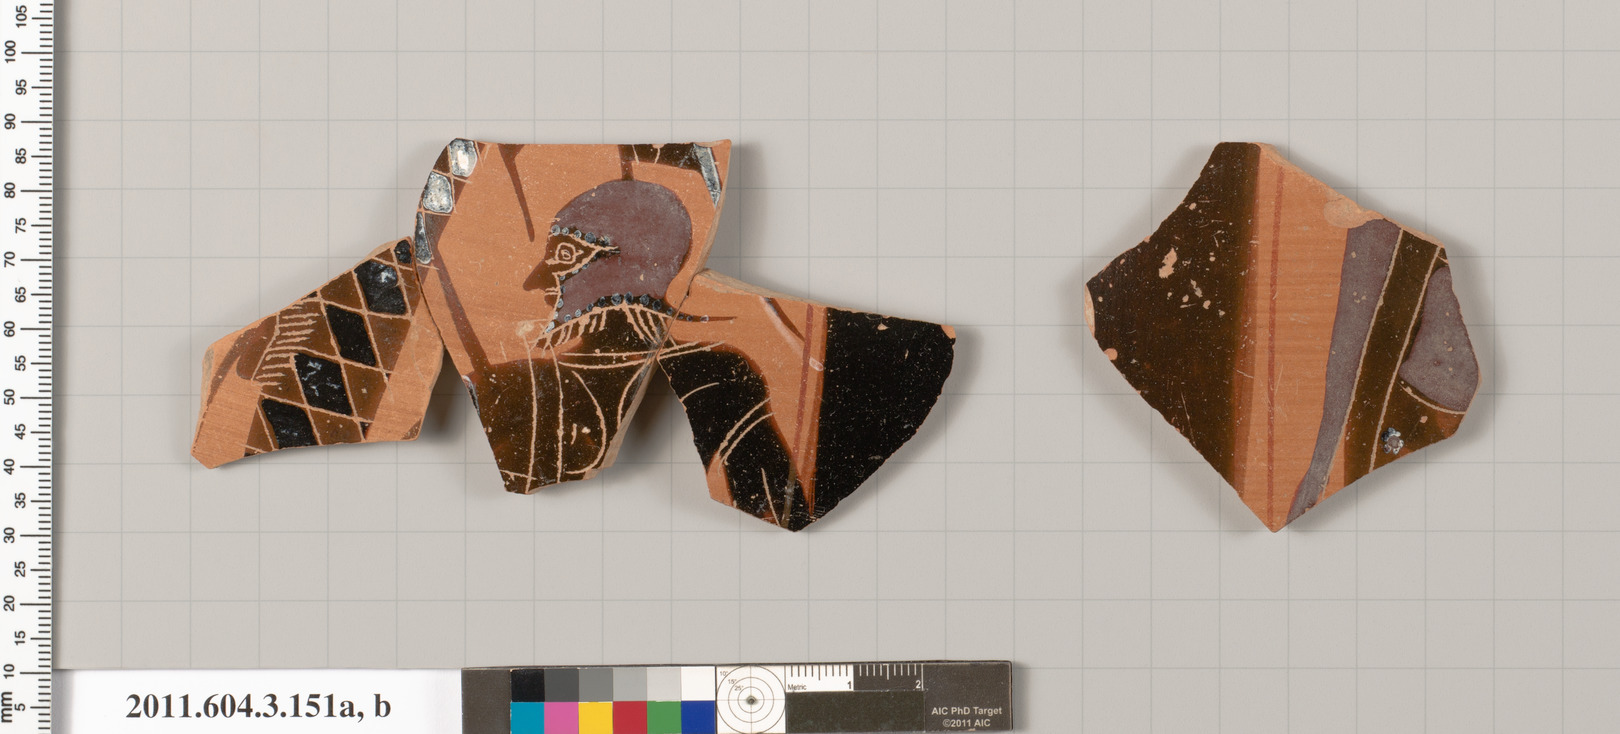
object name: amphora fragment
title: Terracotta fragments of an amphora (jar)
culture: greek, attic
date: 550-540 BCE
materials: terracotta